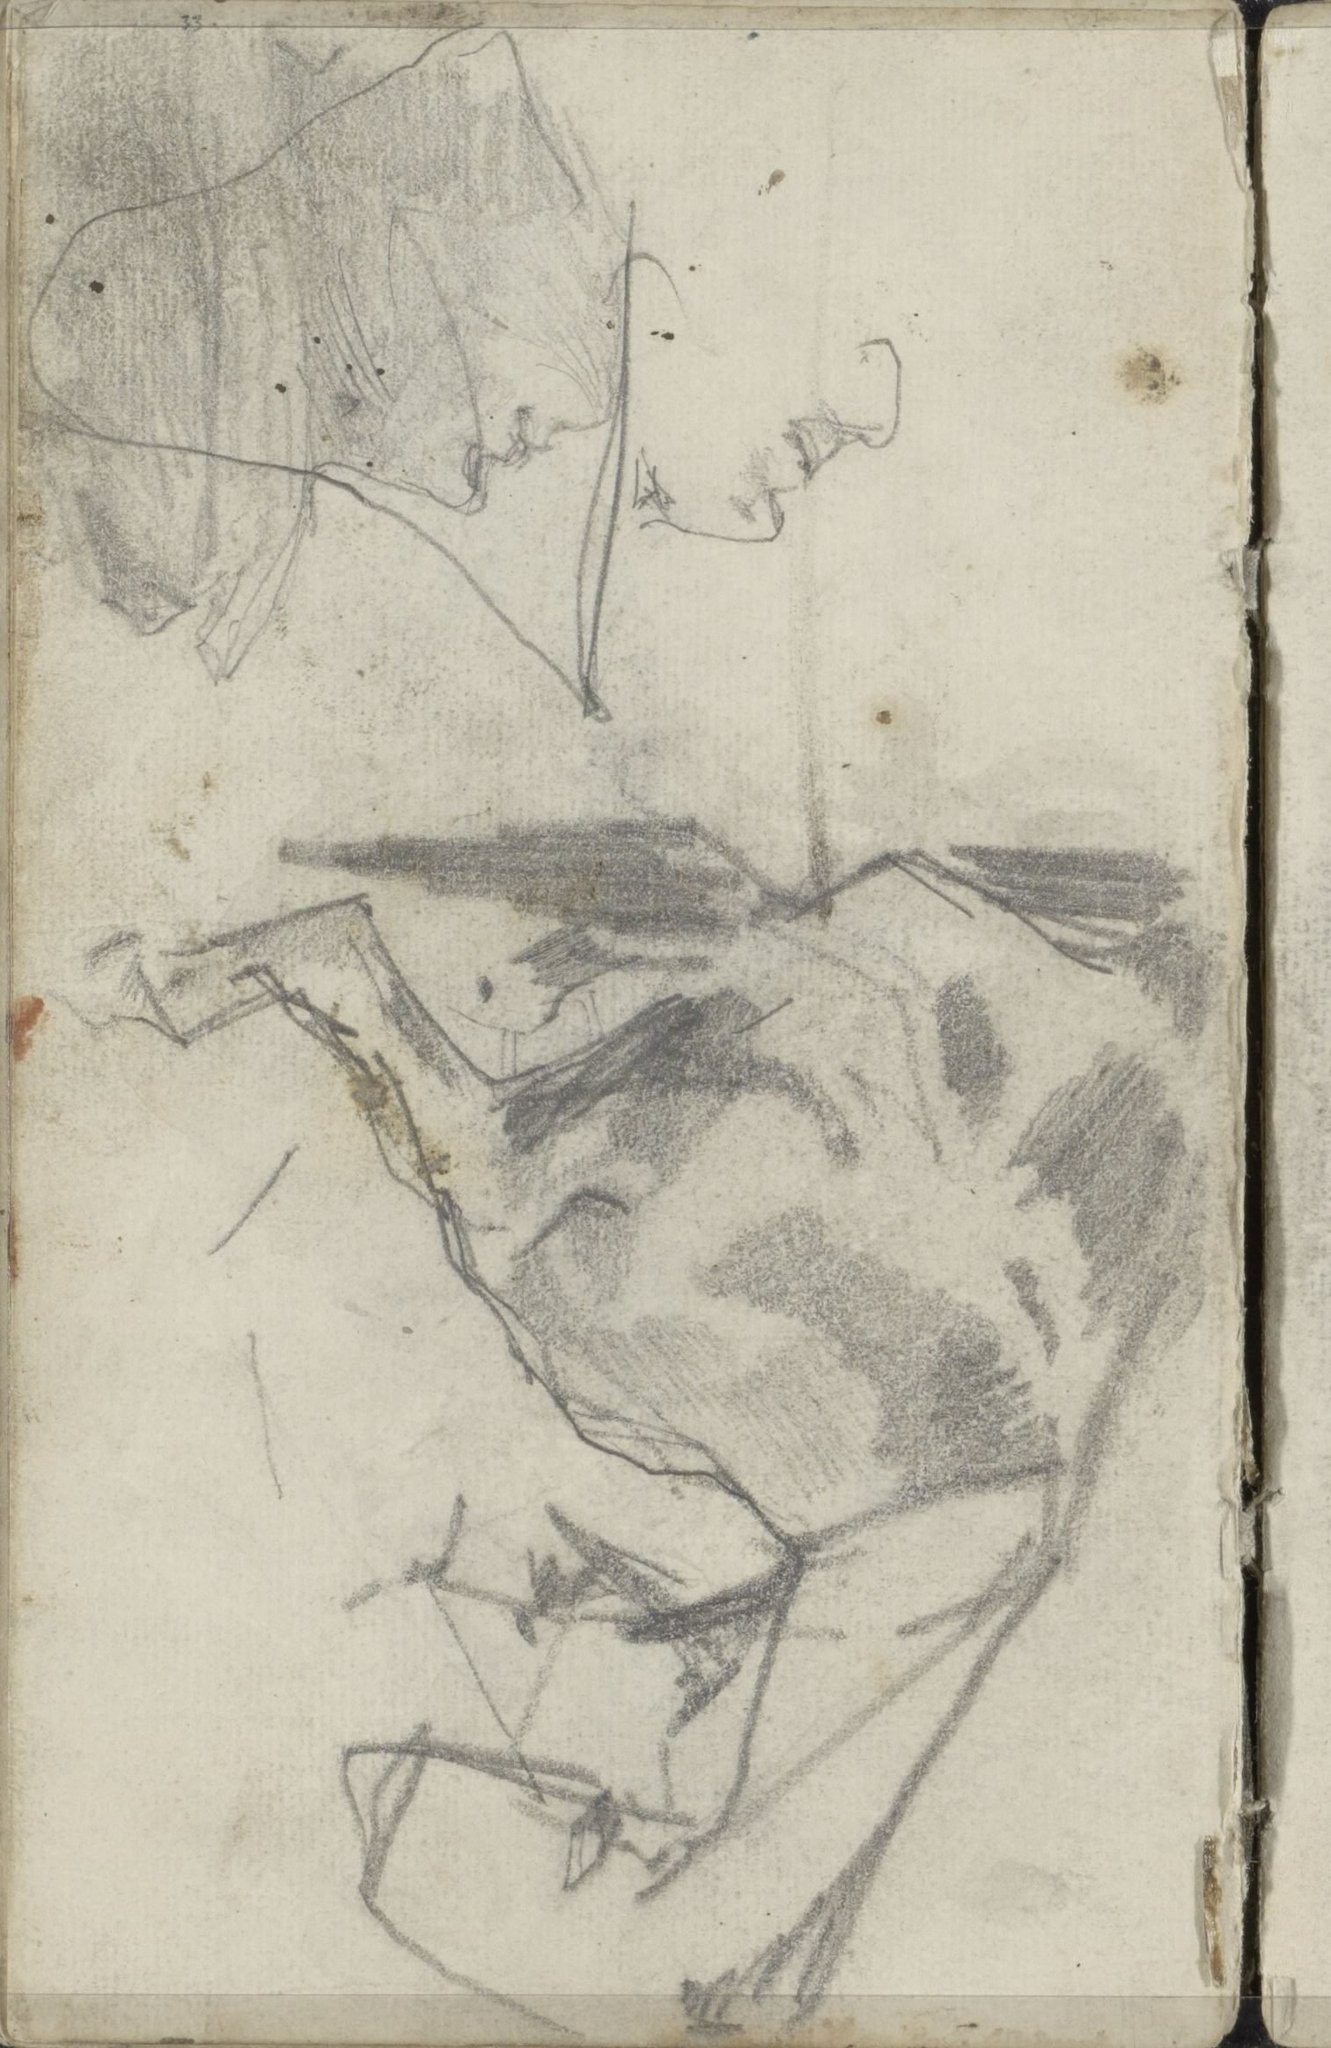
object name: sketchbook leaf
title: Vrouwenhoofd en een paard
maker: george hendrik breitner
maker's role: draughtsman, painter, print maker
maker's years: 1857-1923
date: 1881-1883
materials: paper, pencil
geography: the hague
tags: horse, head (human) - aa - female human figure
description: Pagina 33 uit een schetsboek met 27 bladen